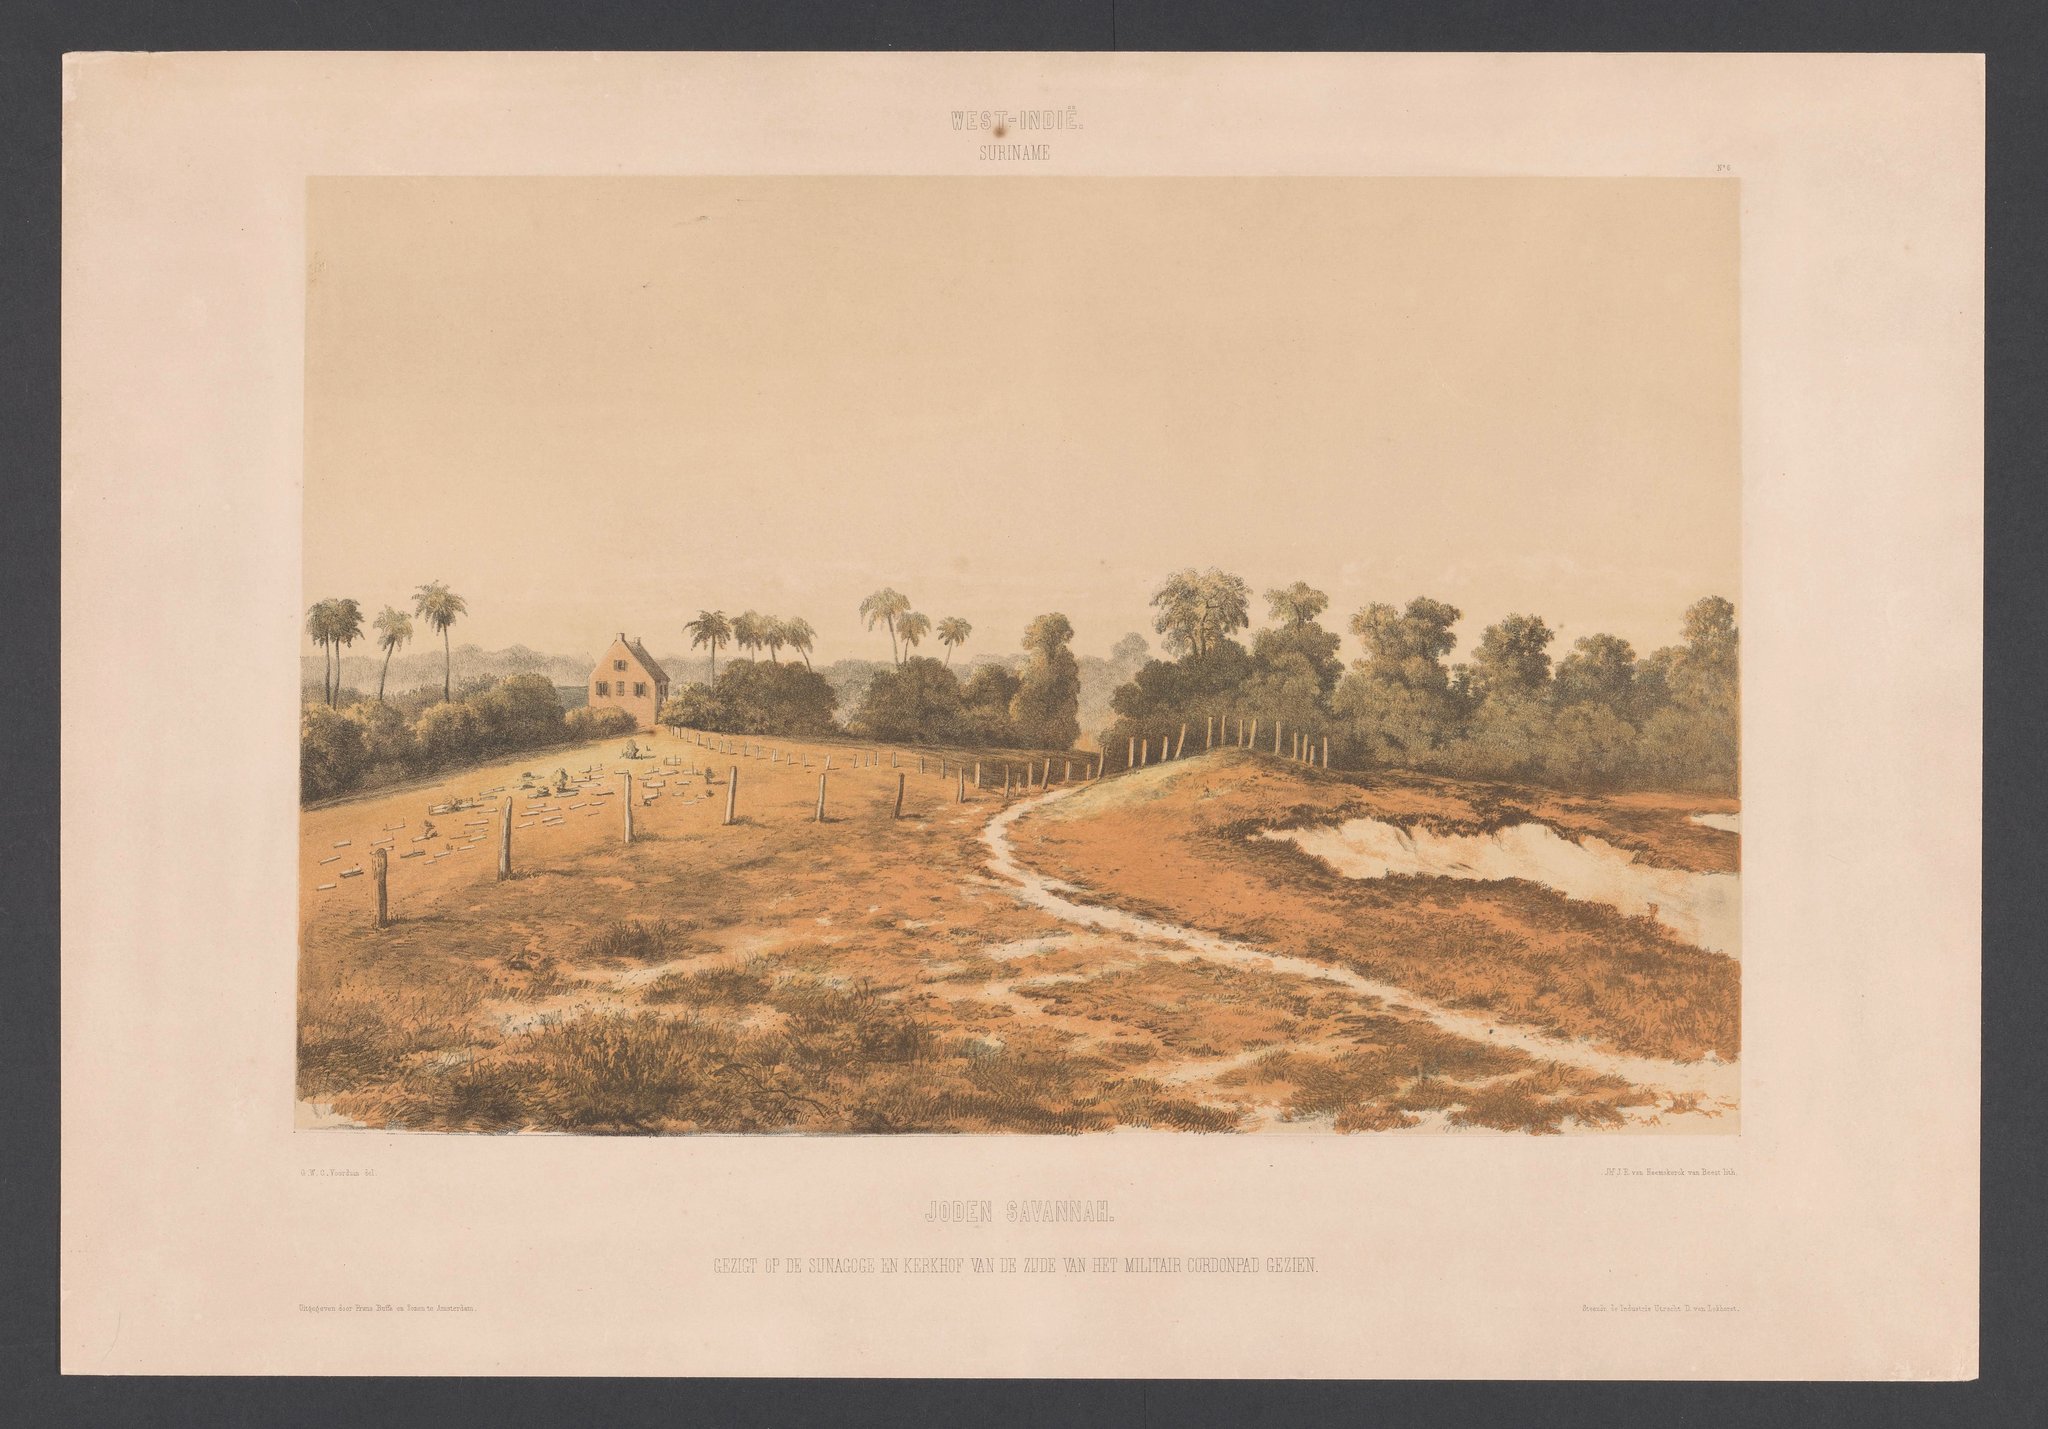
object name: print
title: Gezigten uit Neerland's West-Indien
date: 1860-1862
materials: paper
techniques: lithograph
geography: netherlands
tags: grasslands, savanna, prairie, suriname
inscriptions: collector's mark: Lugt 2228, collector's mark: Lugt 2760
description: Volgens het bijbehorende tekstdeel in aparte omslag betreft dit de zesde prent binnen het plaatwerk 'Gezigten uit Neerland's West-Indien'.